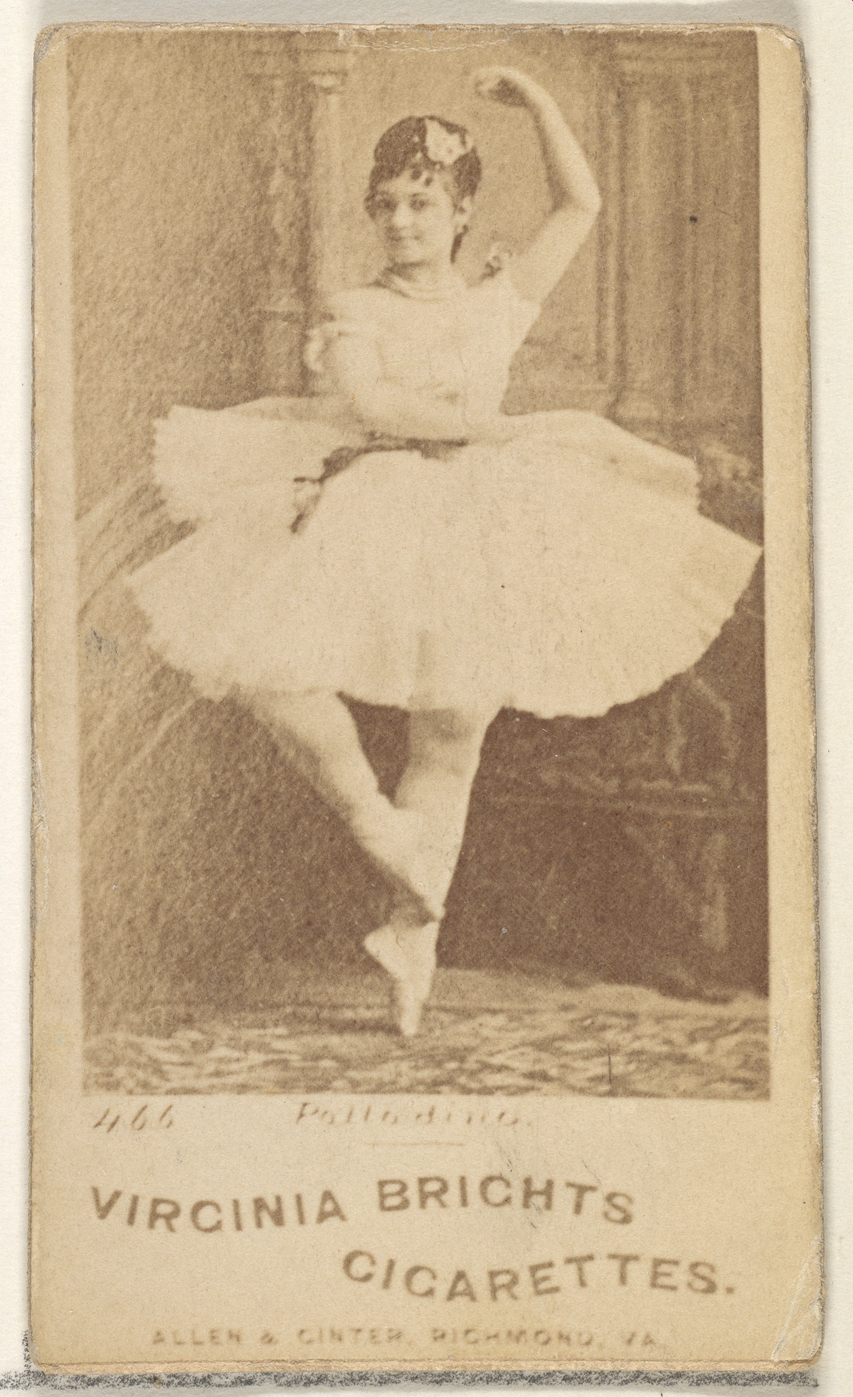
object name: photograph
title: Card 466, Palladina, from the Actors and Actresses series (N45, Type 1) for Virginia Brights Cigarettes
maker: allen & ginter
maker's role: publisher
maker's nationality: american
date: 1888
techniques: albumen silver print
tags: portraits,women,dancers,ballet